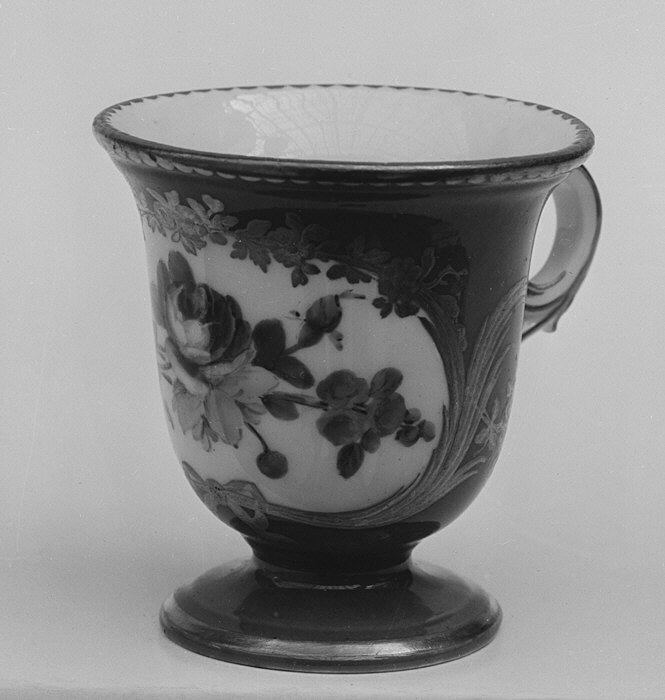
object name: ice cream cup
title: Ice cream cup (tasse à glace) (one of thirty-one) (part of a service)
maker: sèvres manufactory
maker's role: manufactory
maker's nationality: french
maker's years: 1740-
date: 1780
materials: soft paste porcelain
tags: flowers